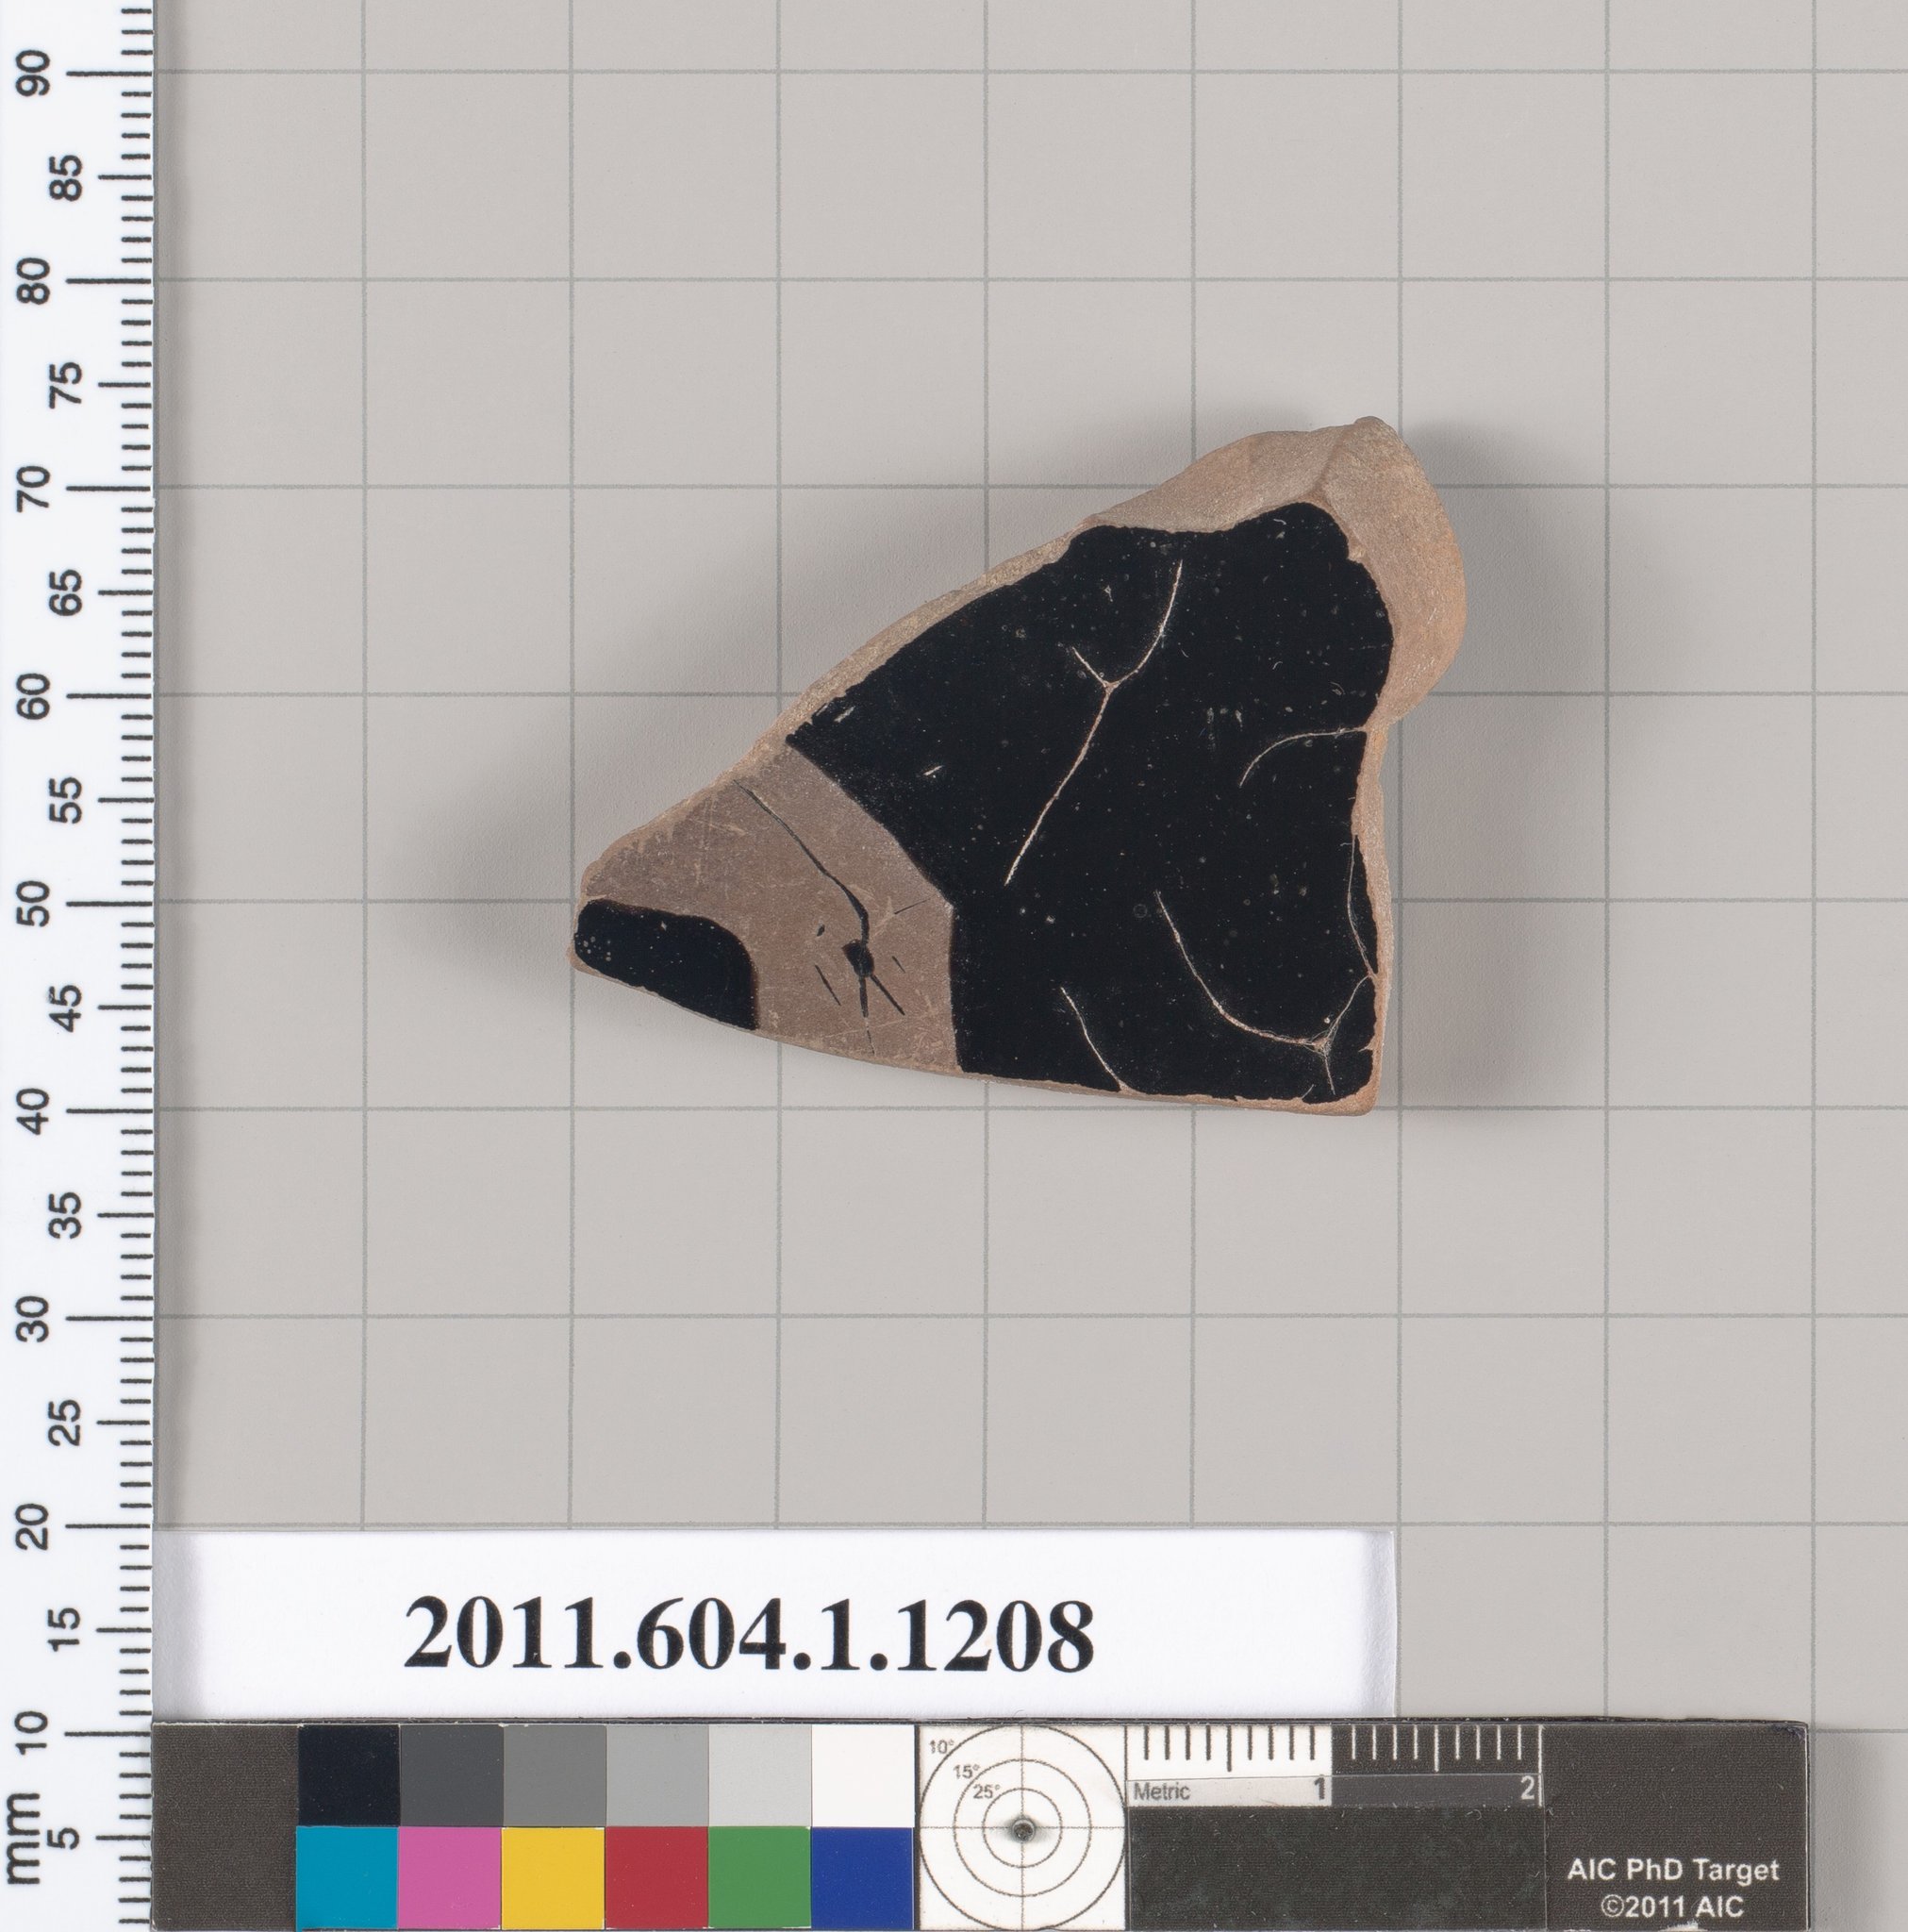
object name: kylix fragment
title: Terracotta fragment of a kylix (drinking cup)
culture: greek, attic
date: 475-451 BCE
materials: terracotta